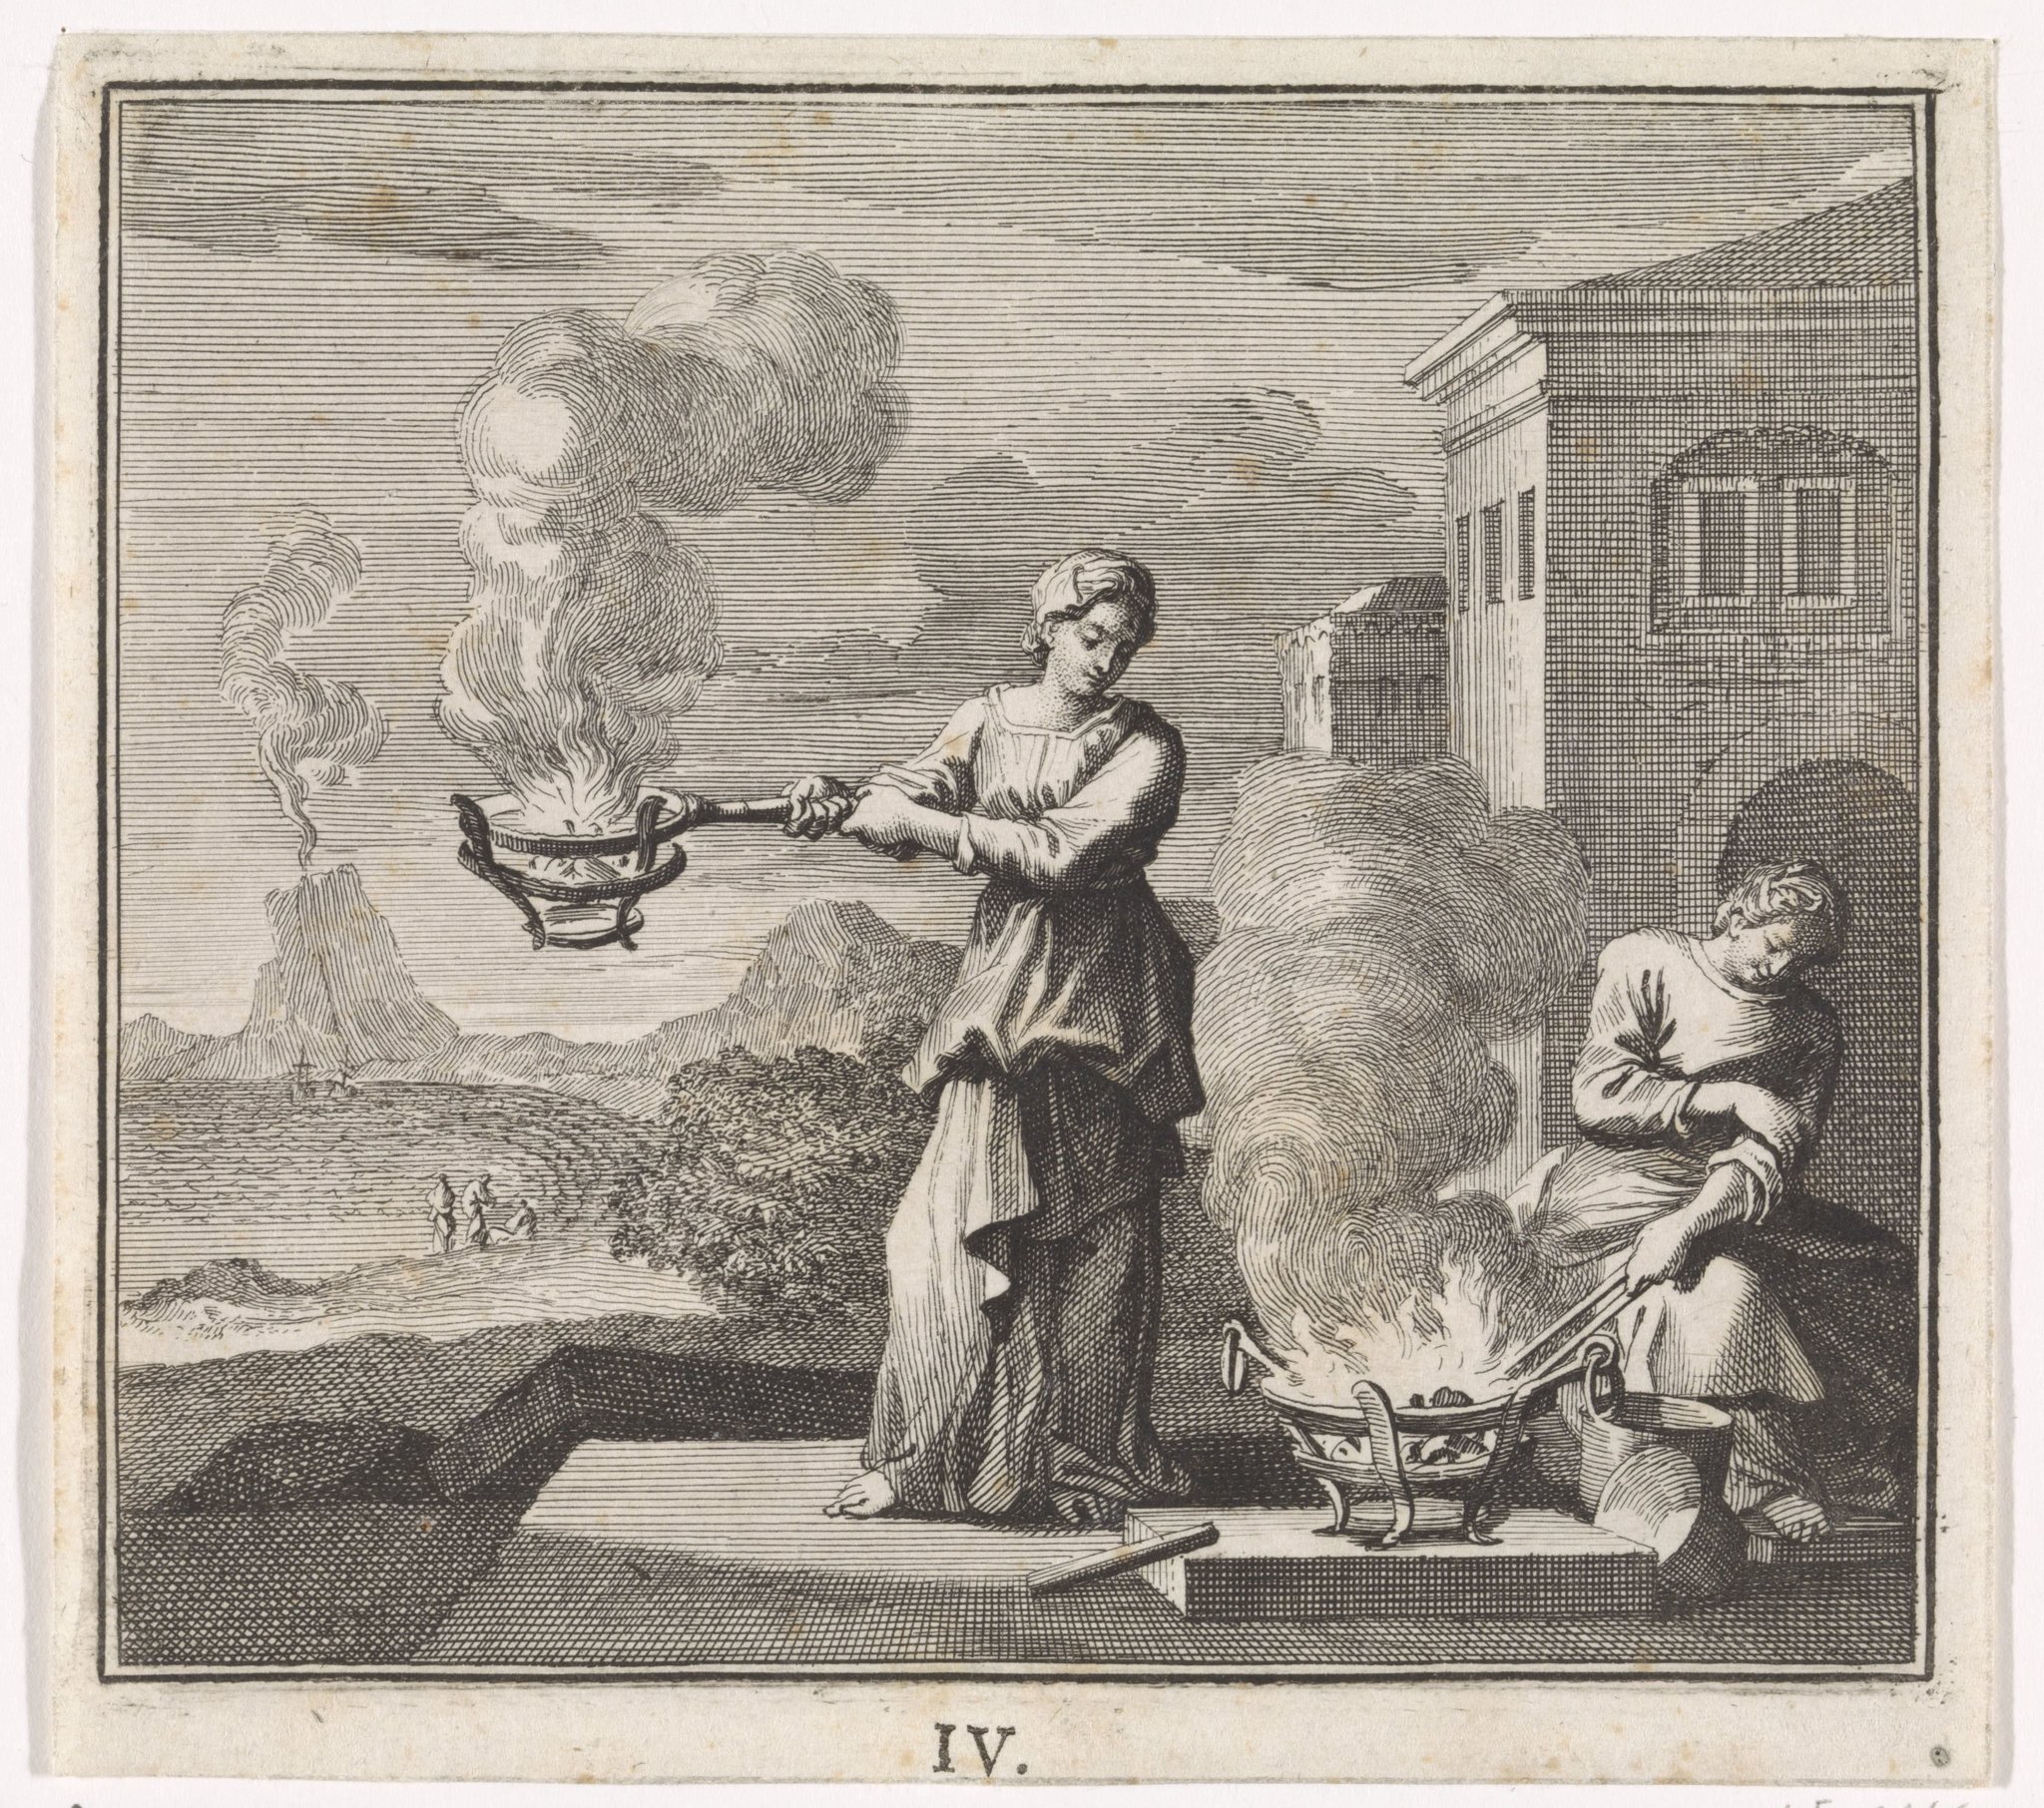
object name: book illustration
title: Embleem: vuur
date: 1695-1705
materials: paper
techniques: etching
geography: nuremberg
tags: fire (one of the four elements), warming oneself at a fire (or hearth, stove, fire-pan, brazier), open fire (in general), volcano, open fire, fire-place, stove (in kitchen) - cc - in the open air, abstract ideas and concepts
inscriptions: collector's mark: Lugt 2228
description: Boekillustratie voor Weigel, Christoph. Ethica Naturalis seu Documenta Moralia e Variis rerum Naturalium proprietatibus Virtutum Vitiorumq symbolicis imaginibus collecta. Neurenberg: Christoph Weigel: c. 1700.